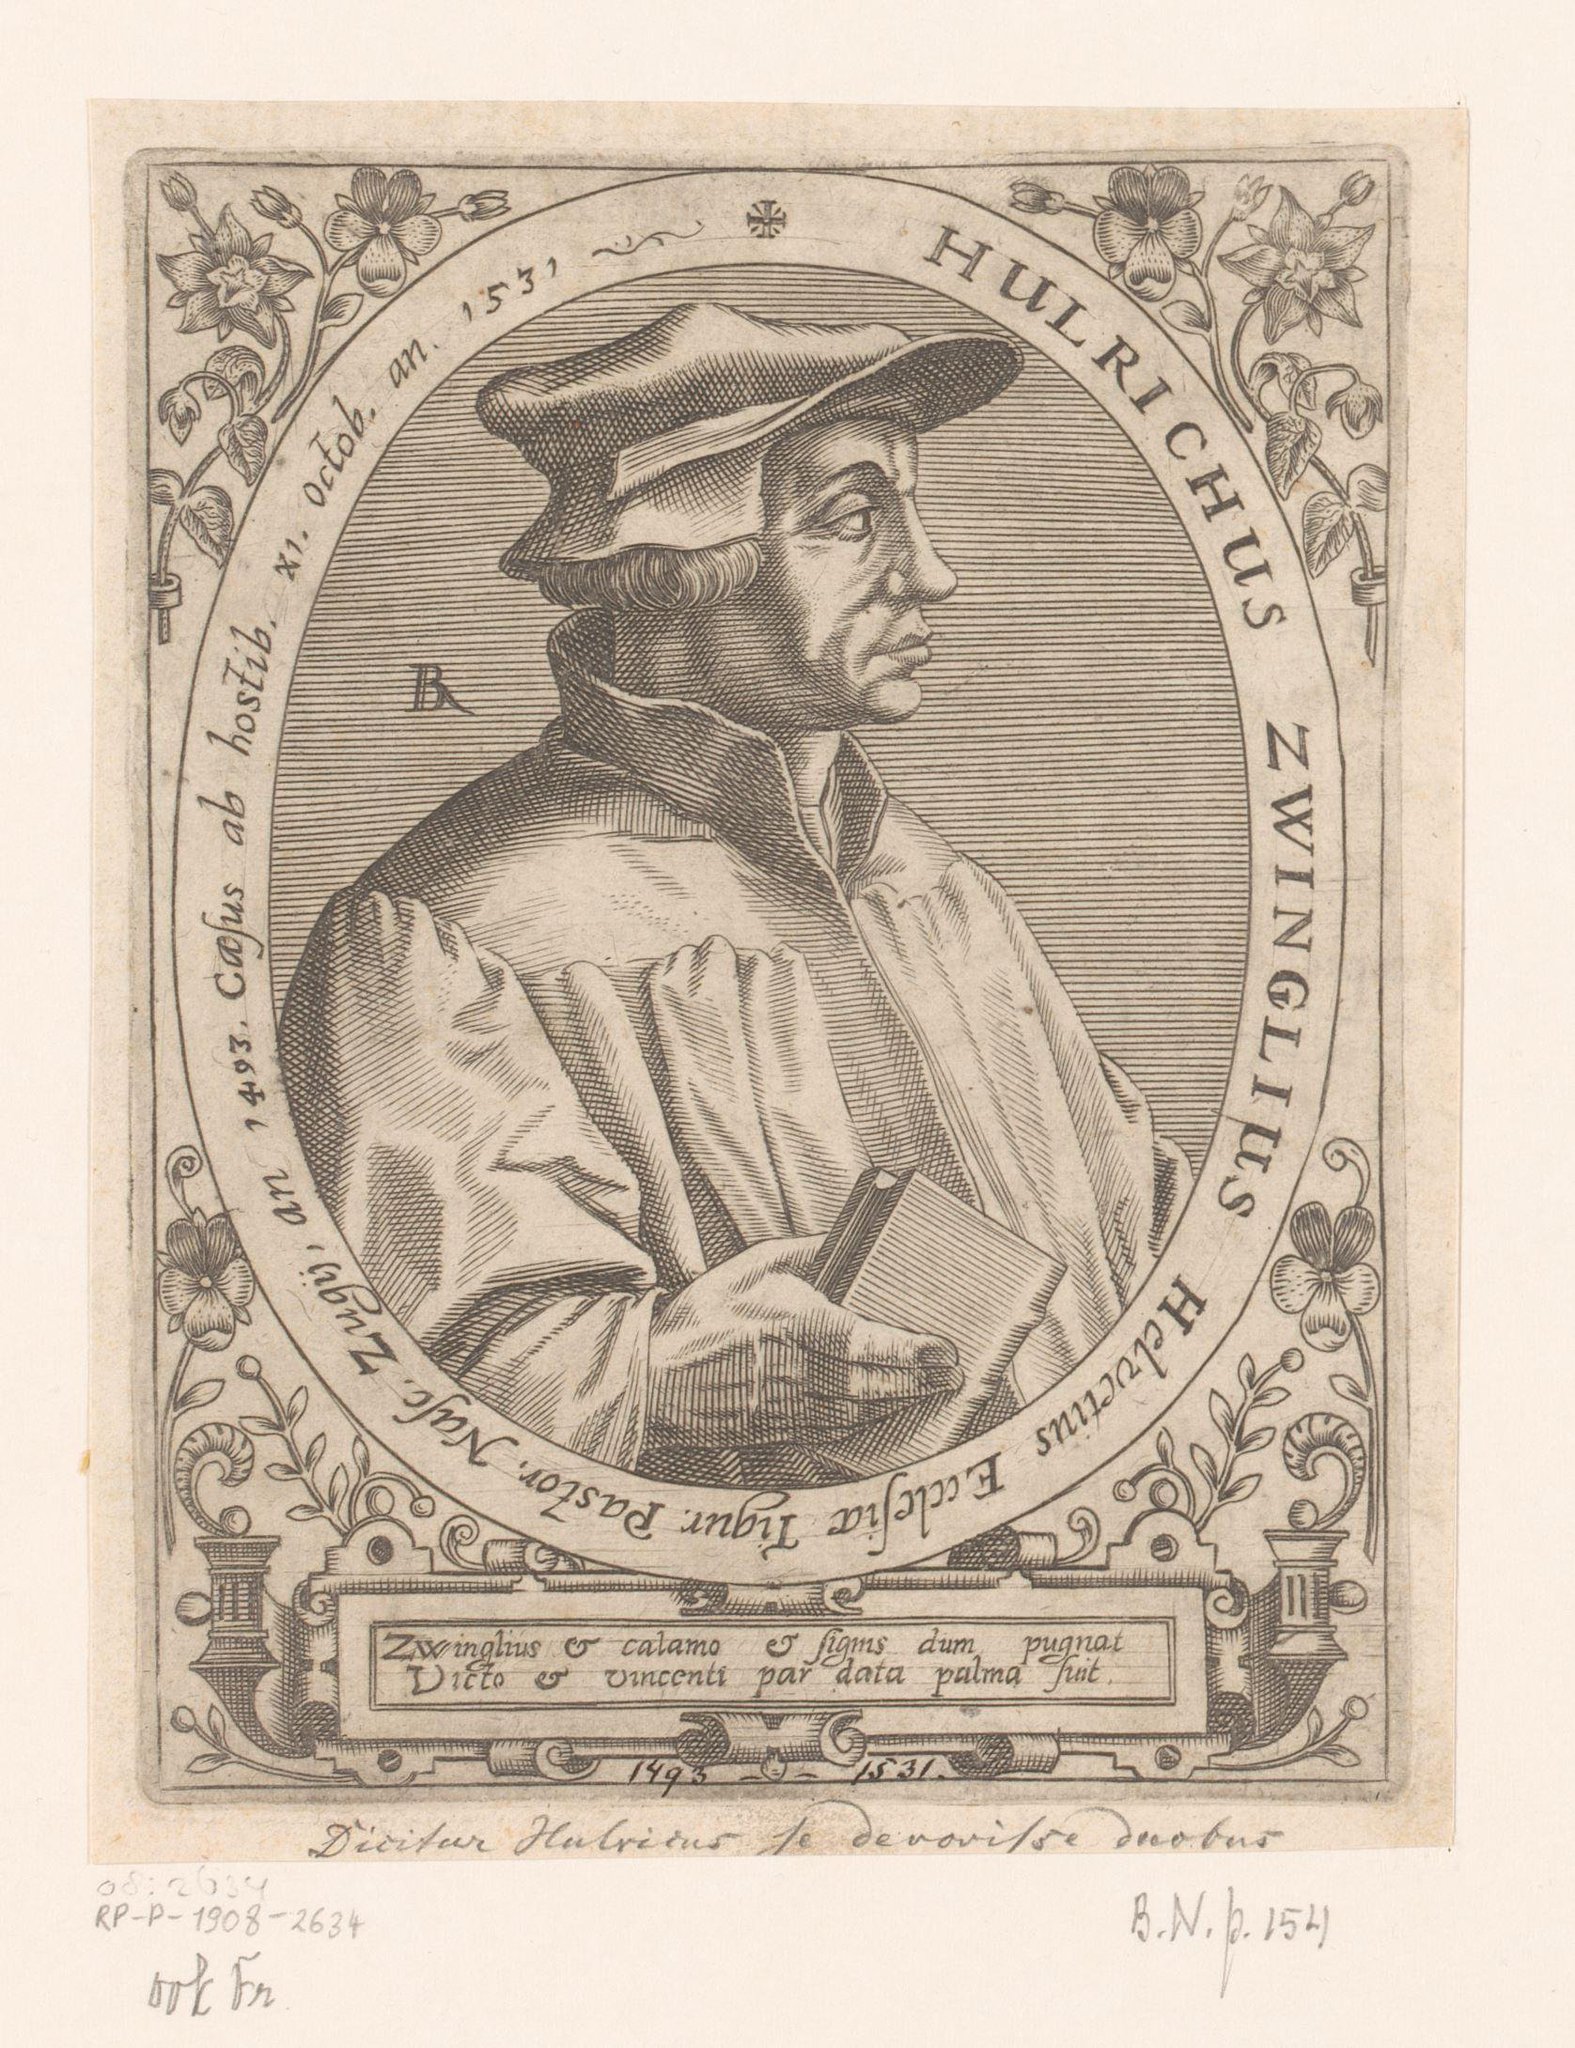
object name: print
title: Serie portretten van vijftiende- en zestiende-eeuwse geleerden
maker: robert boissard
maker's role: print maker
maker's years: 1570-1611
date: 1597-1599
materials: paper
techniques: engraving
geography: france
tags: clergyman, flowers ~ ornament - aa - stylized, historical persons, book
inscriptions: collector's mark: Lugt 2228, inscription: ‘c est Martinus Zuifnam: Chemnitiusille Tridentinorum dogmta discutiens: (...)’